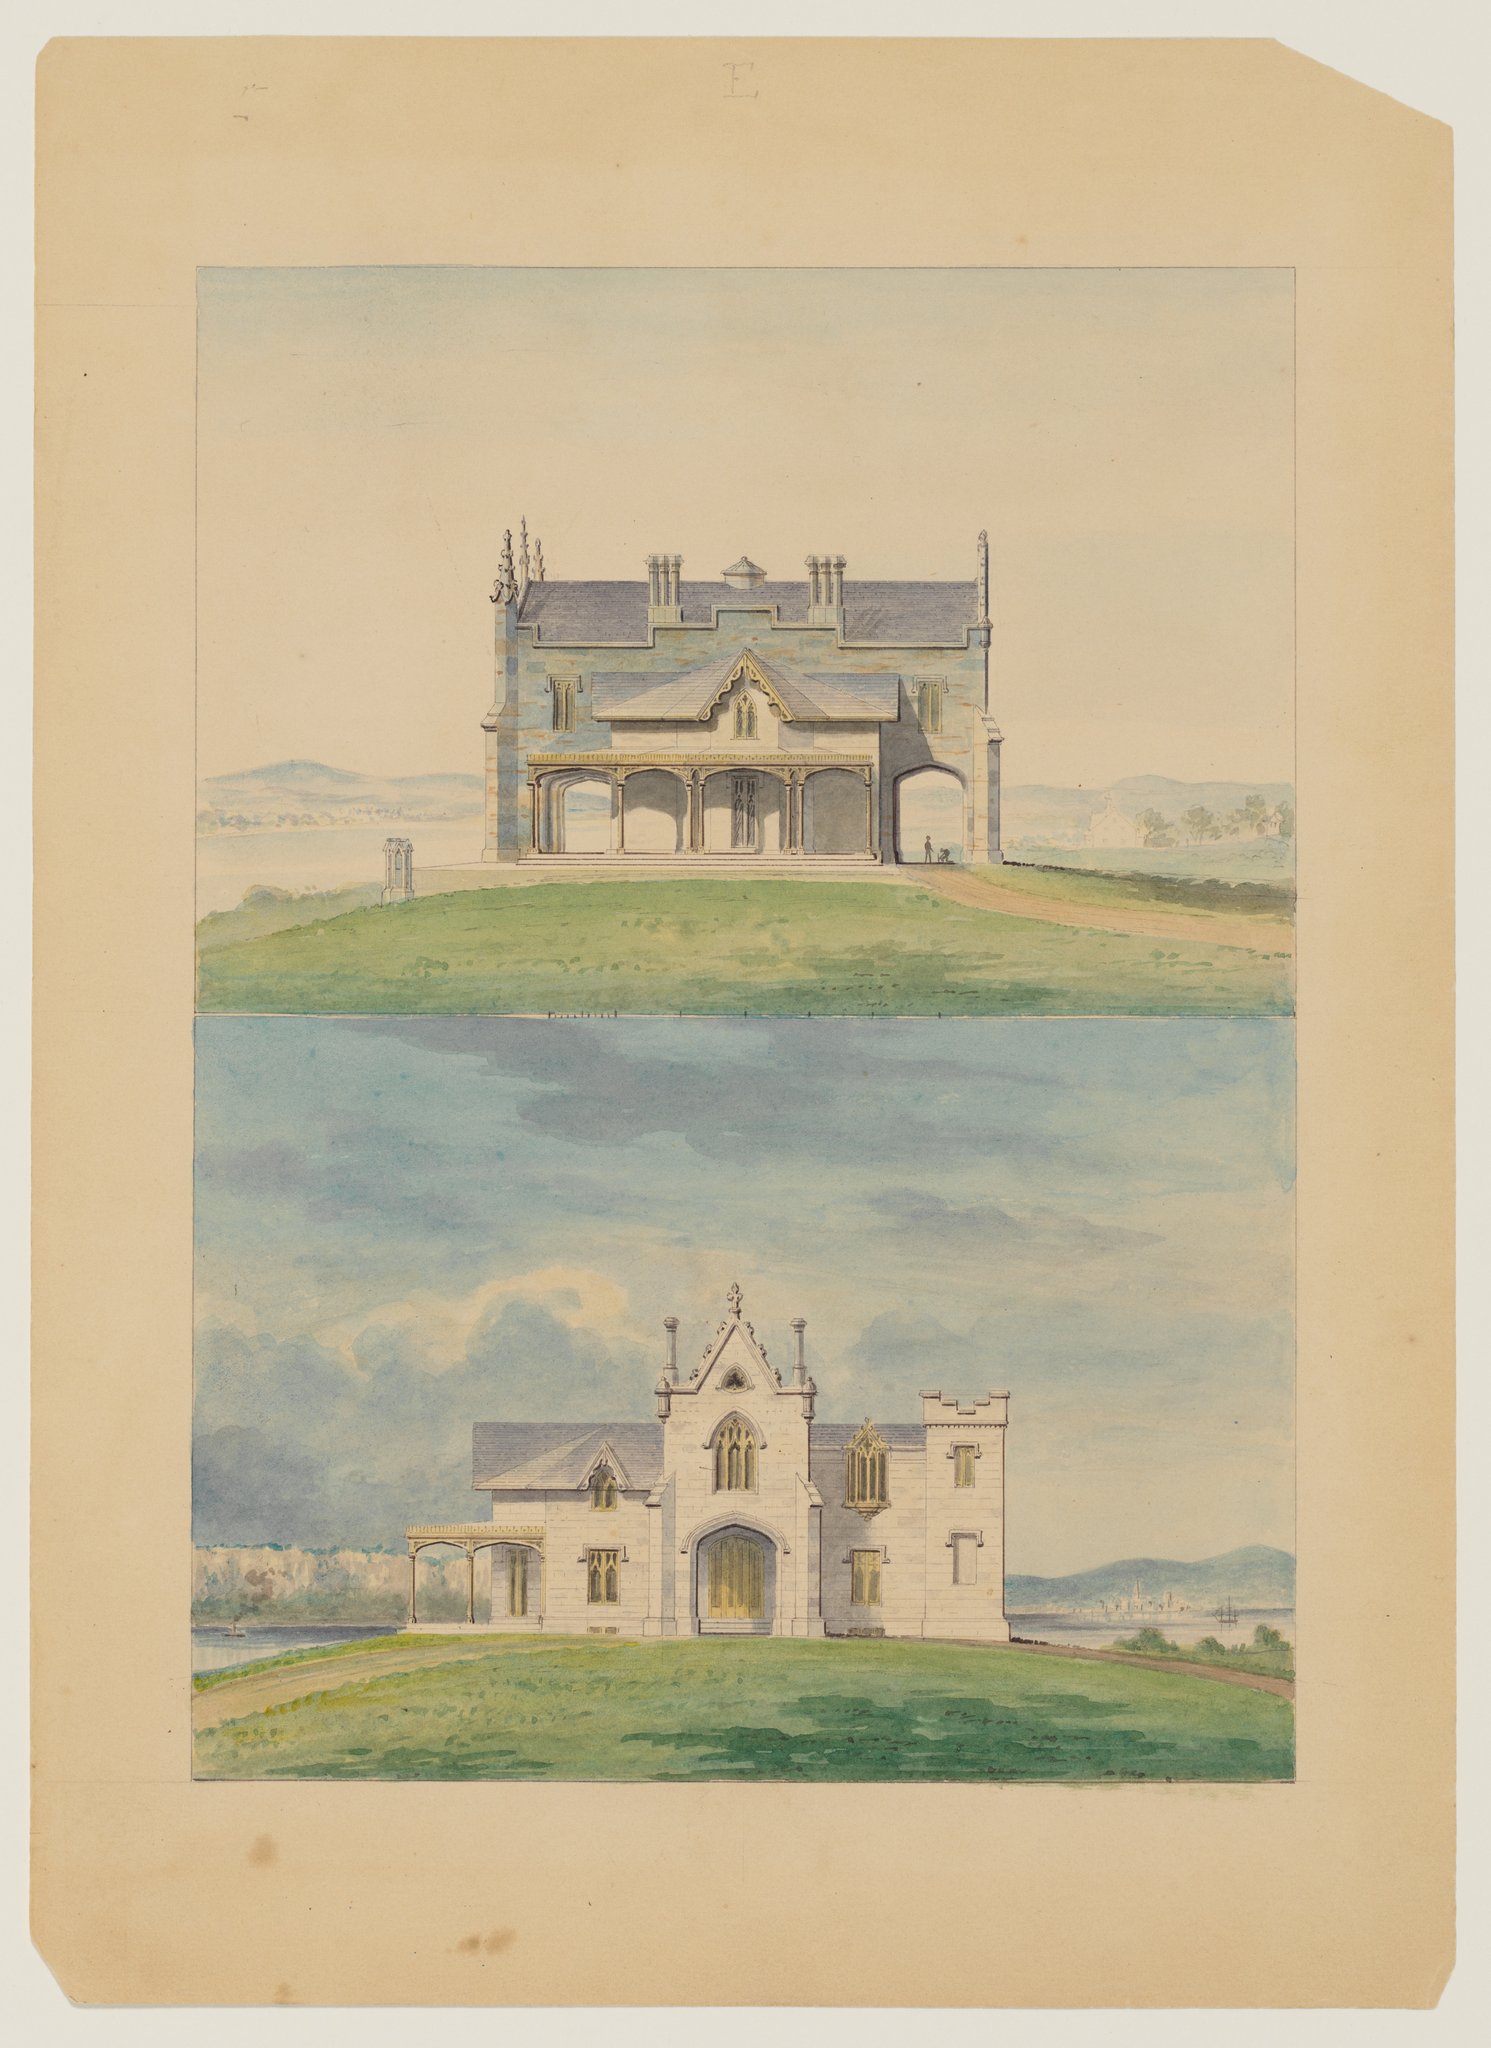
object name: drawing ornament architecture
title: Knoll for William and Philip R. Paulding, Tarrytown (south and east [front] elevations)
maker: alexander jackson davis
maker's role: artist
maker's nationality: american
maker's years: 1803-1892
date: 1838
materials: ink, paper, watercolor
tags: architecture,houses